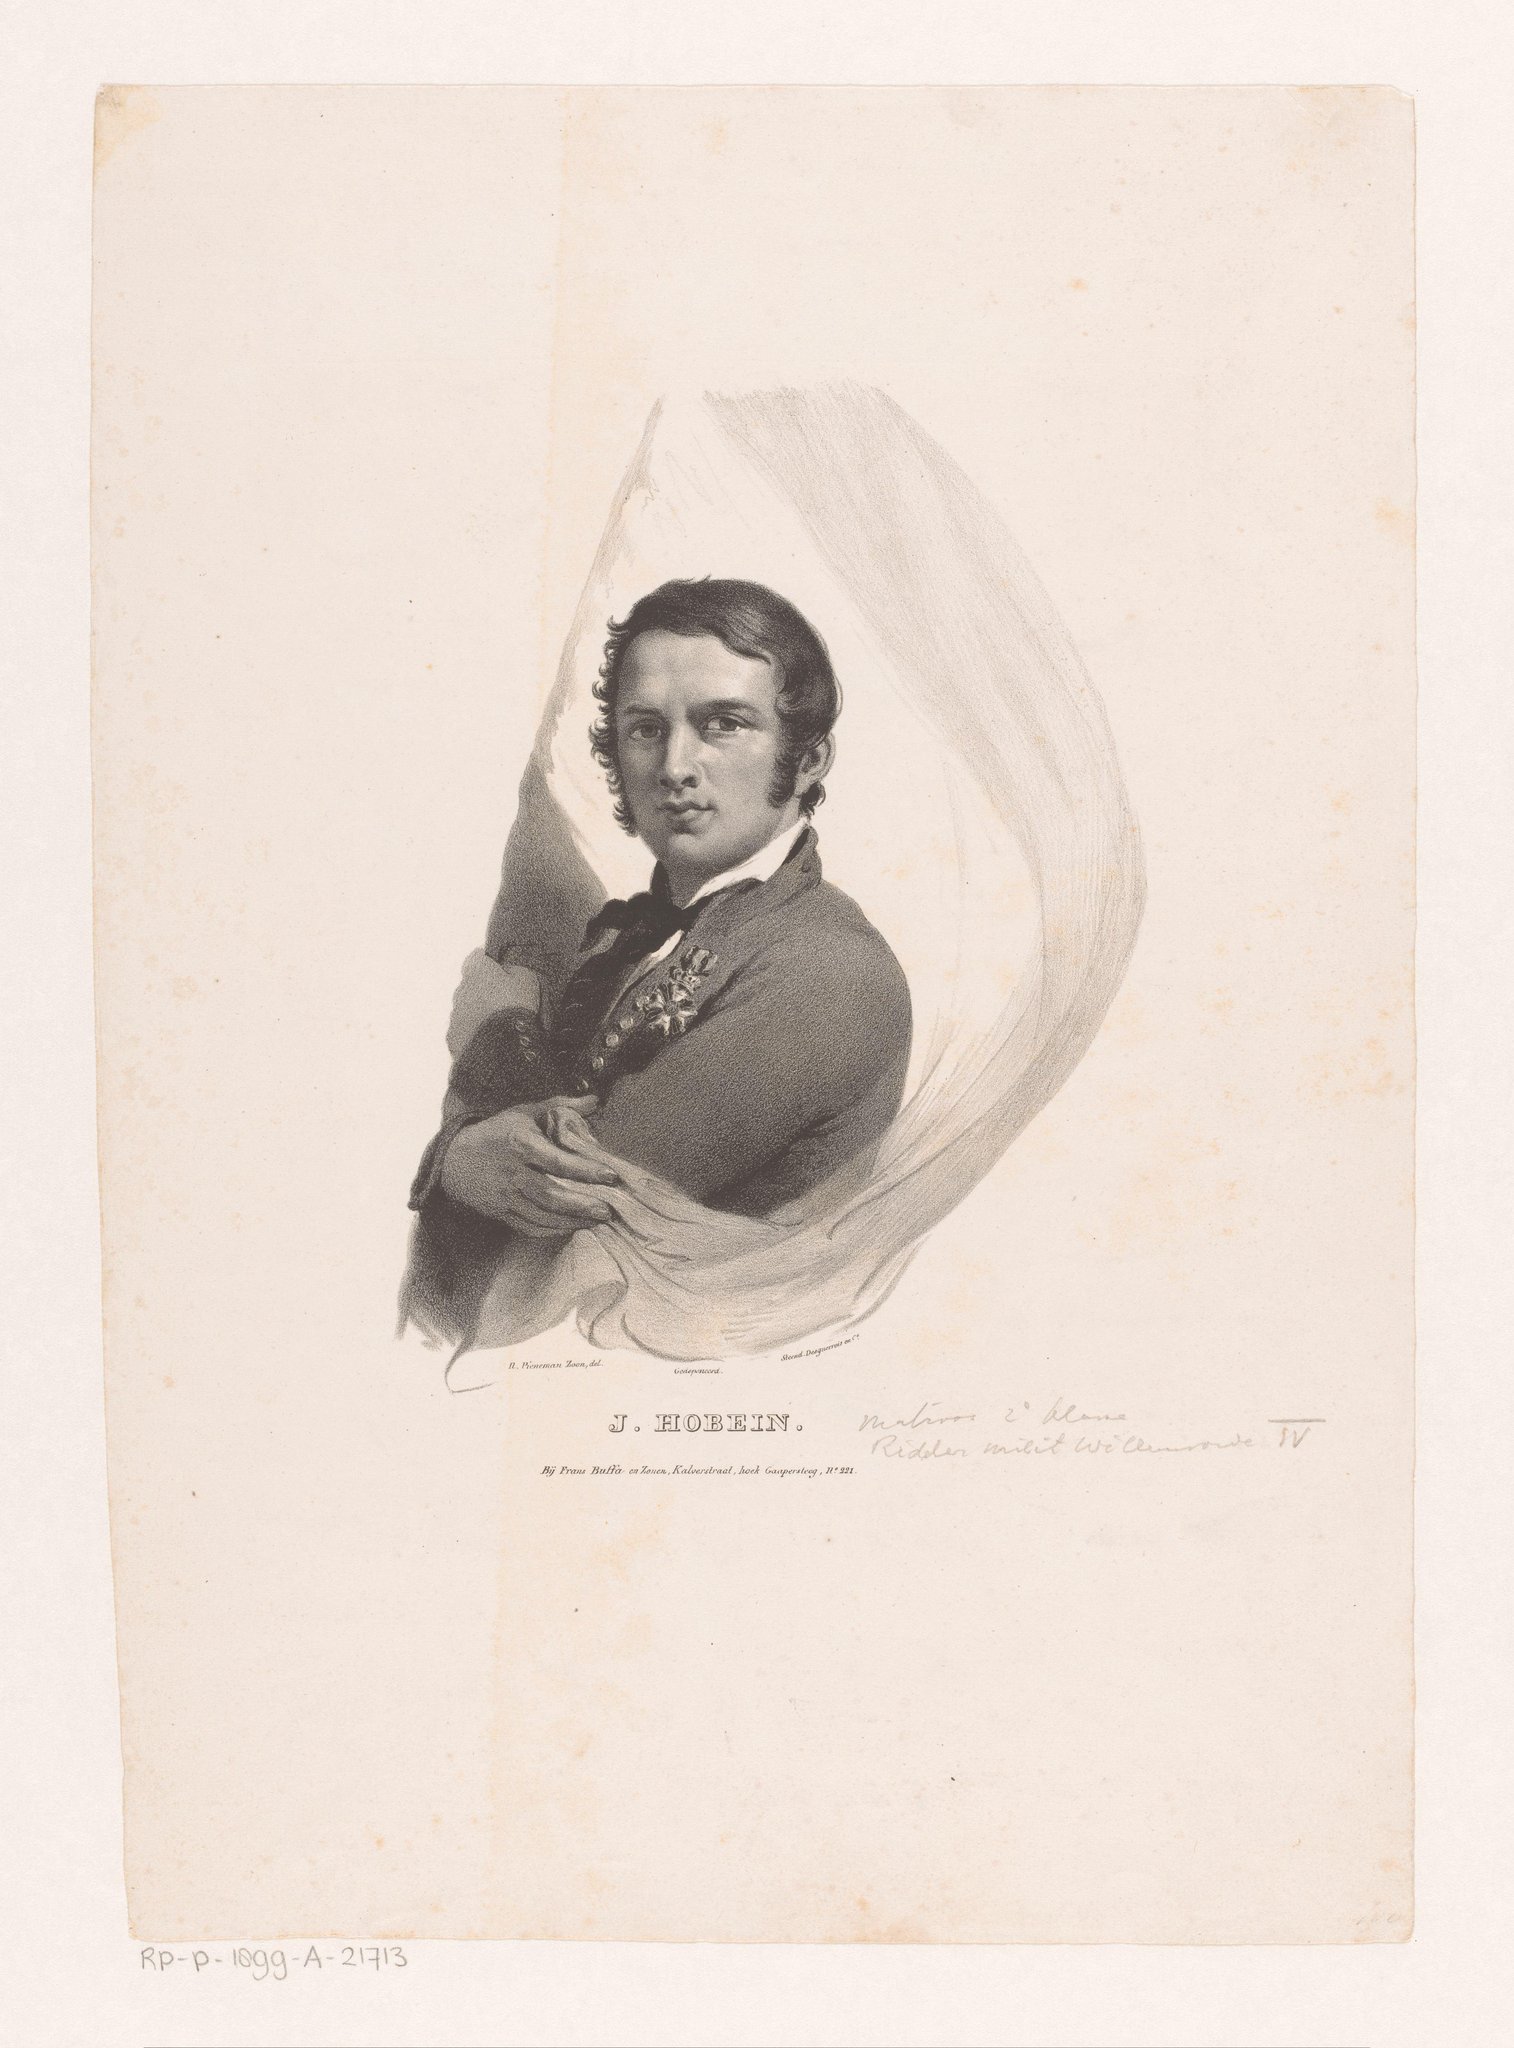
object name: print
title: Portret van Jacob Hobein met vlag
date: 1831-1853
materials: paper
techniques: lithograph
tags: historical persons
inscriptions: : ‘Gedeponeerd.’, collector's mark: Lugt 2228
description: 19 maart 1831 haalde Jacob Hobein de Nederlandse vlag weg van een sloep, toen die in handen van de opstandelingen dreigde te vallen.